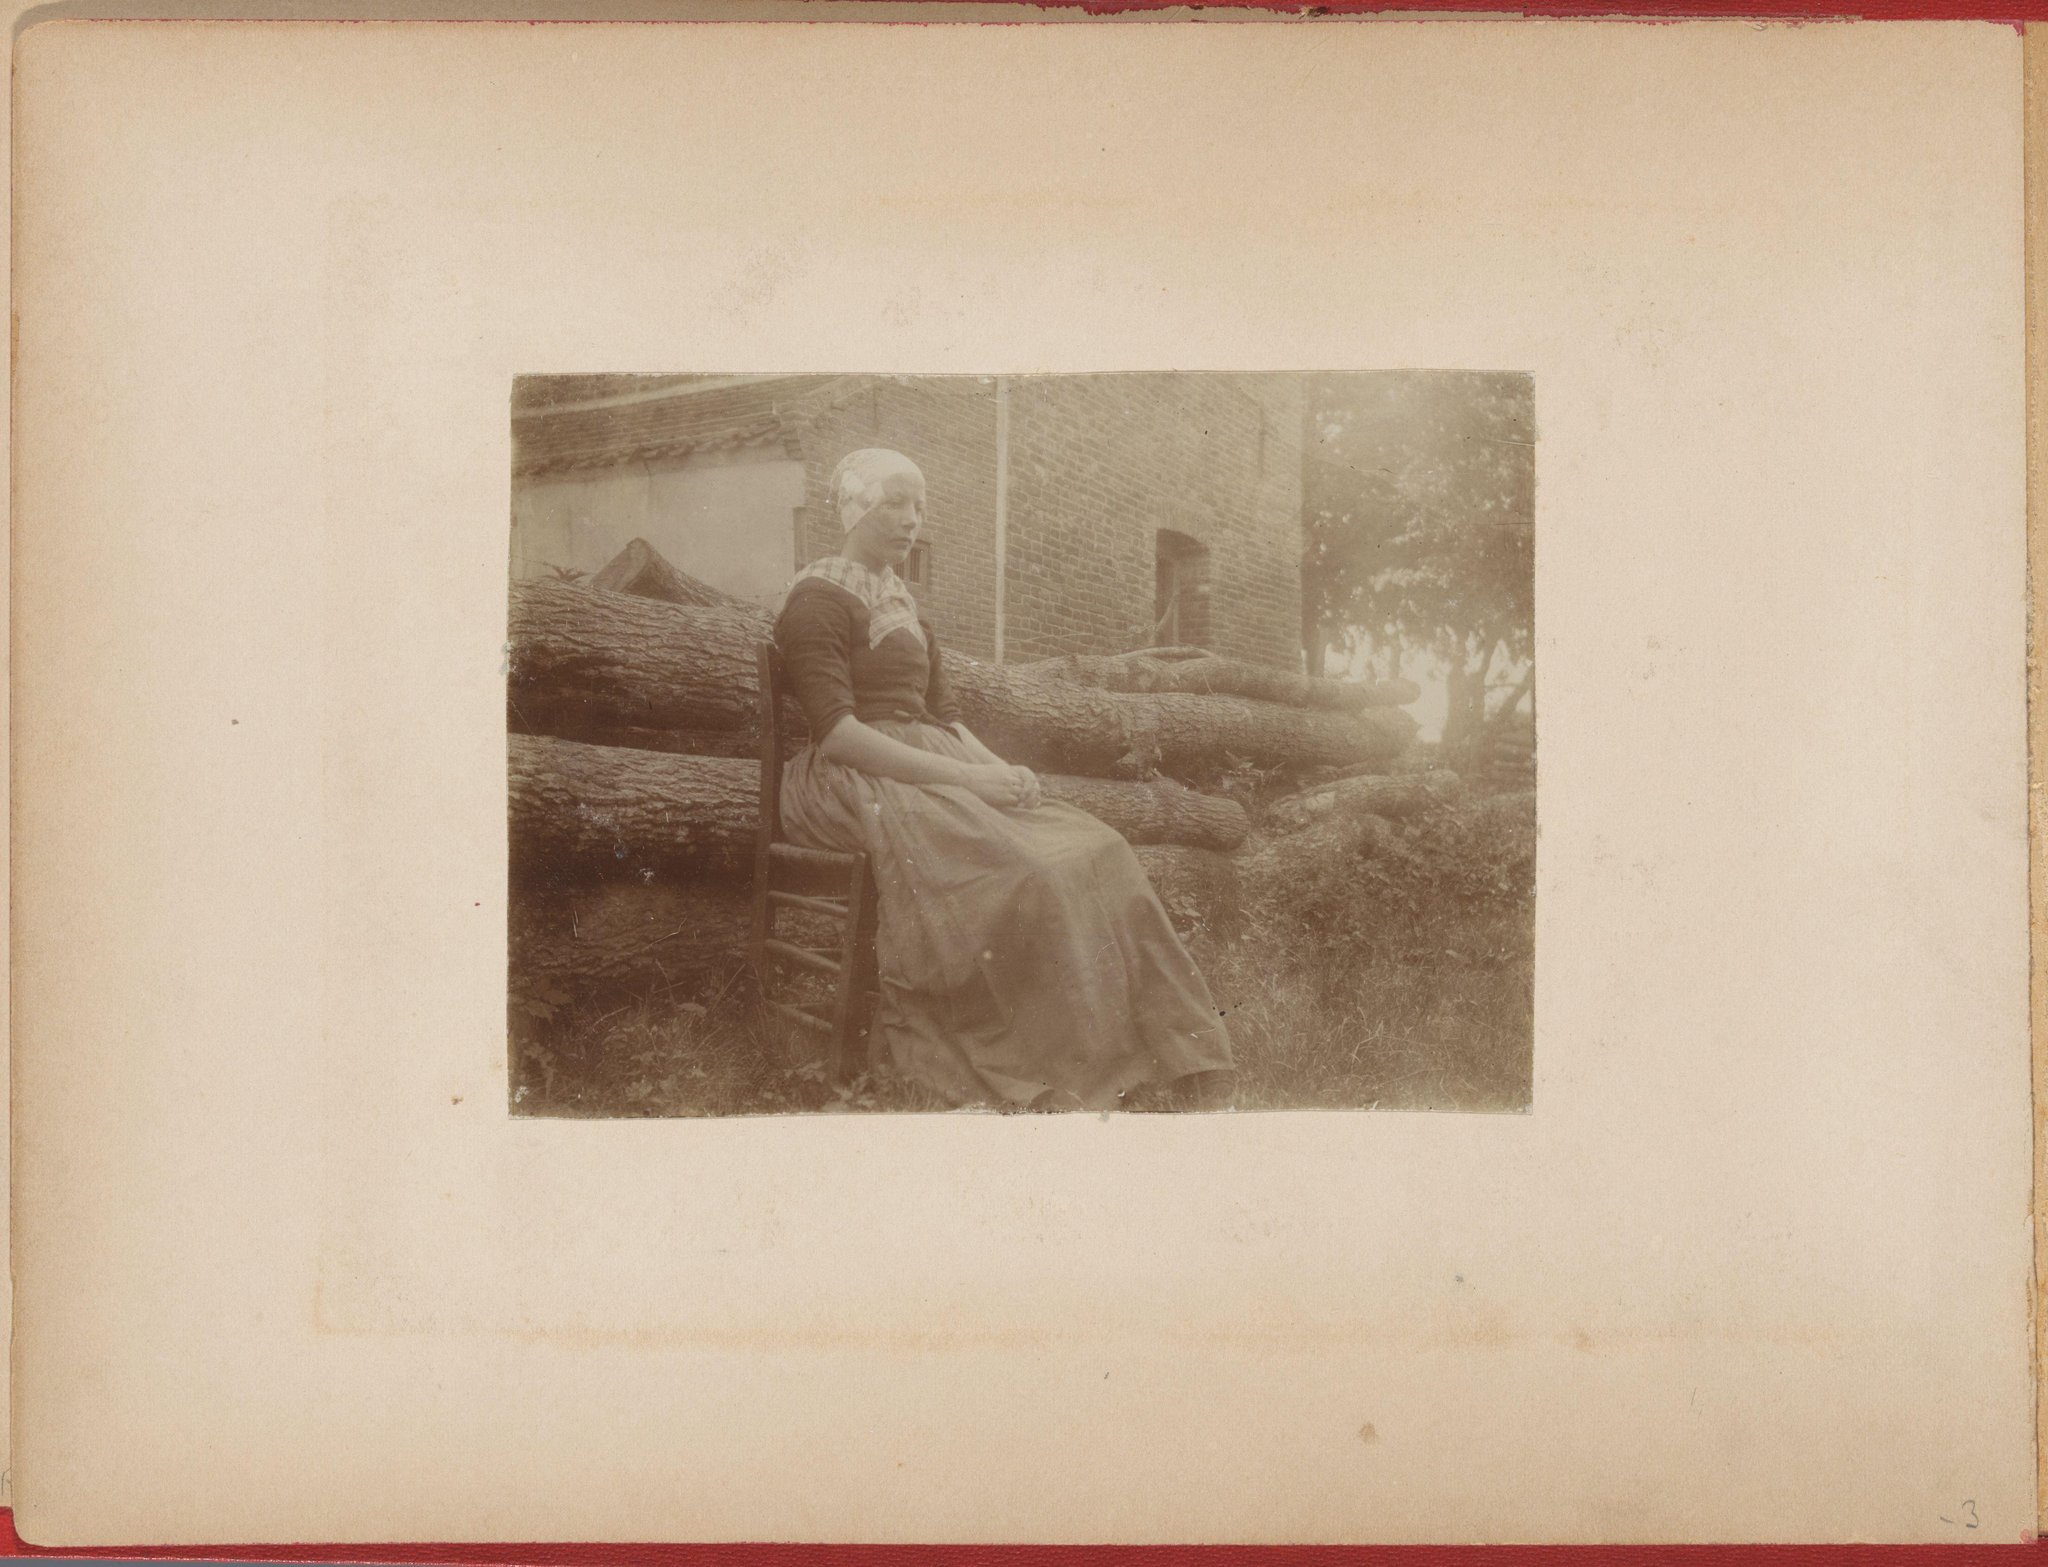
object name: photograph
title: Hendrikje buiten zittend op stoel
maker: gerard aalbersberg (us)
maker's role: amateurfotograaf, arts, chirurg, gynaecoloog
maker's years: 1870-1934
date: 1809-1897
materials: paper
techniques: collodion silver print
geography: nunspeet